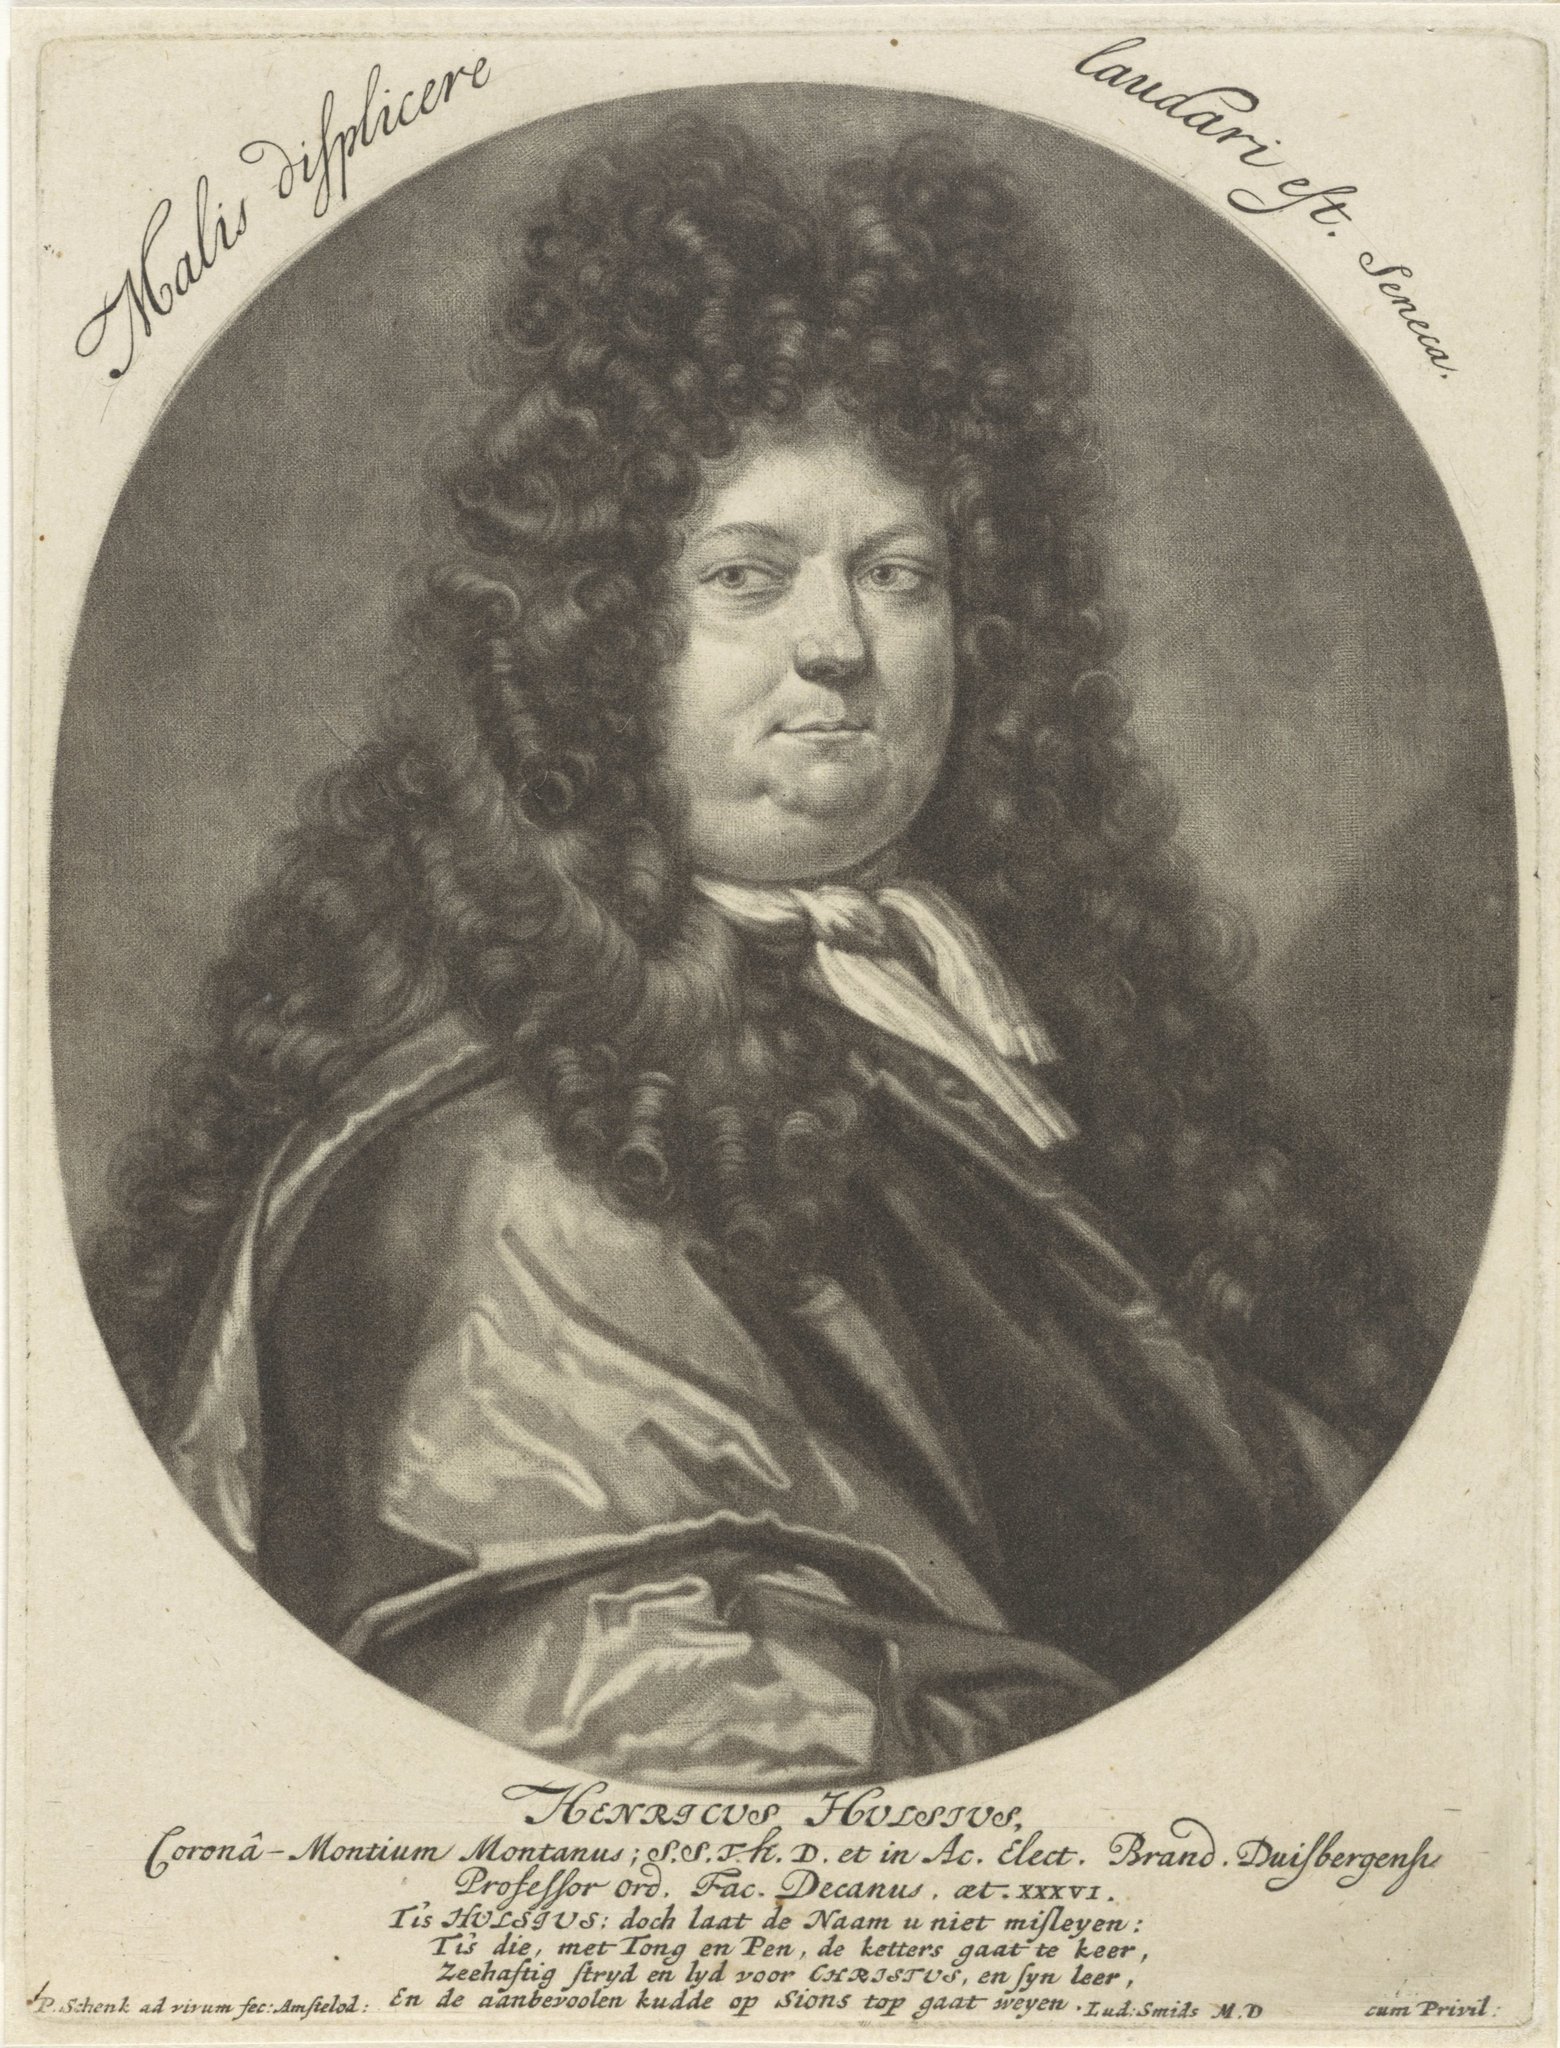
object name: print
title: Portret van Henricus Huls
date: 1670-1713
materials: paper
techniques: engraving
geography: amsterdam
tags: wig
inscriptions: collector's mark: Lugt 2228